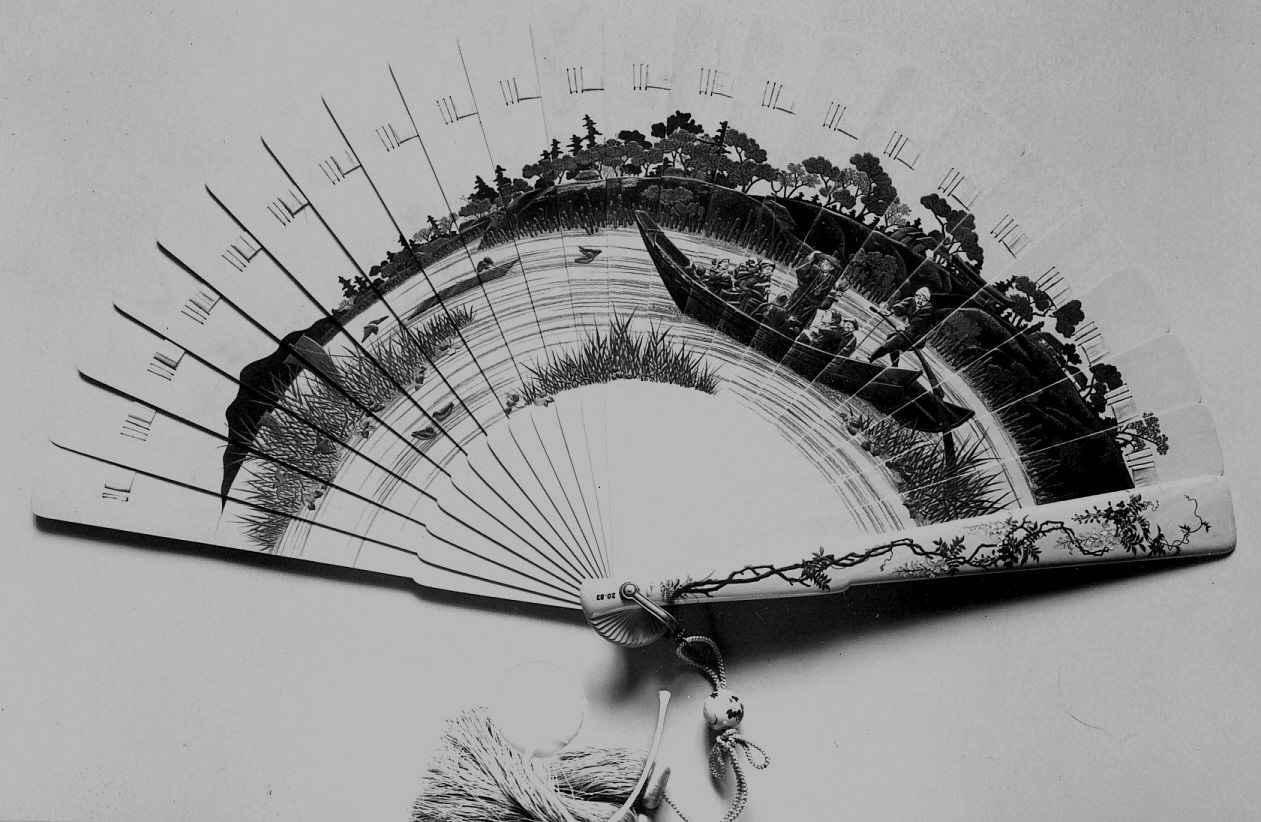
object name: fan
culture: japanese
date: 1767-1833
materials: ivory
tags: human figures,boats